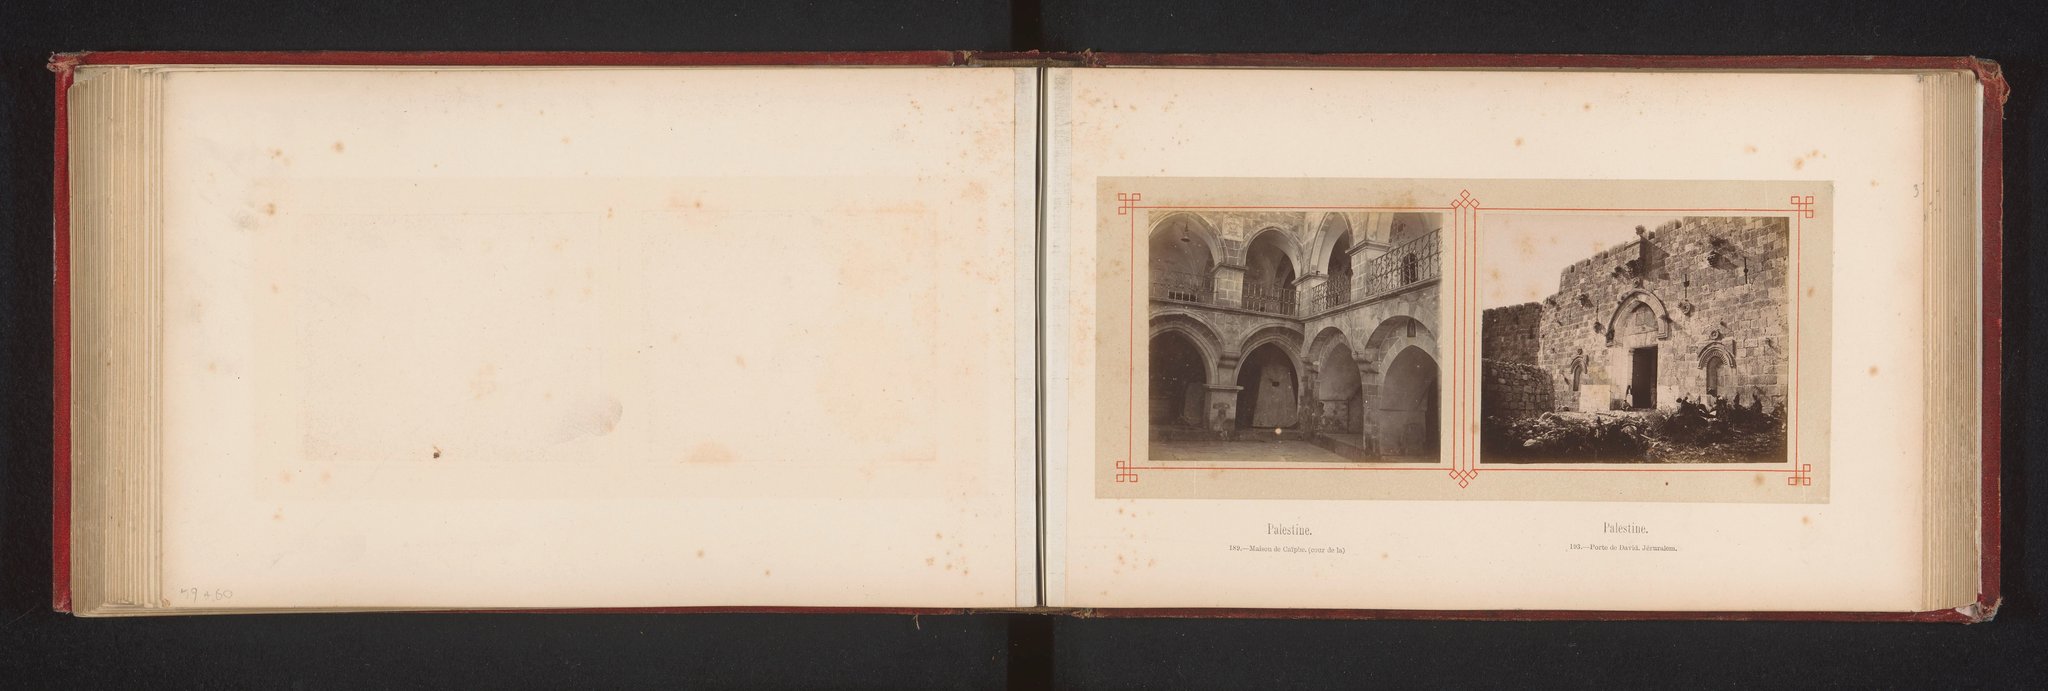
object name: photograph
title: Gezicht op bogen in het huis van Kajafas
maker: félix bonfils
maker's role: fotograaf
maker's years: 1831-1885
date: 1873-1878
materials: photographic support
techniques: albumen print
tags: arch, archivolt ~ architecture